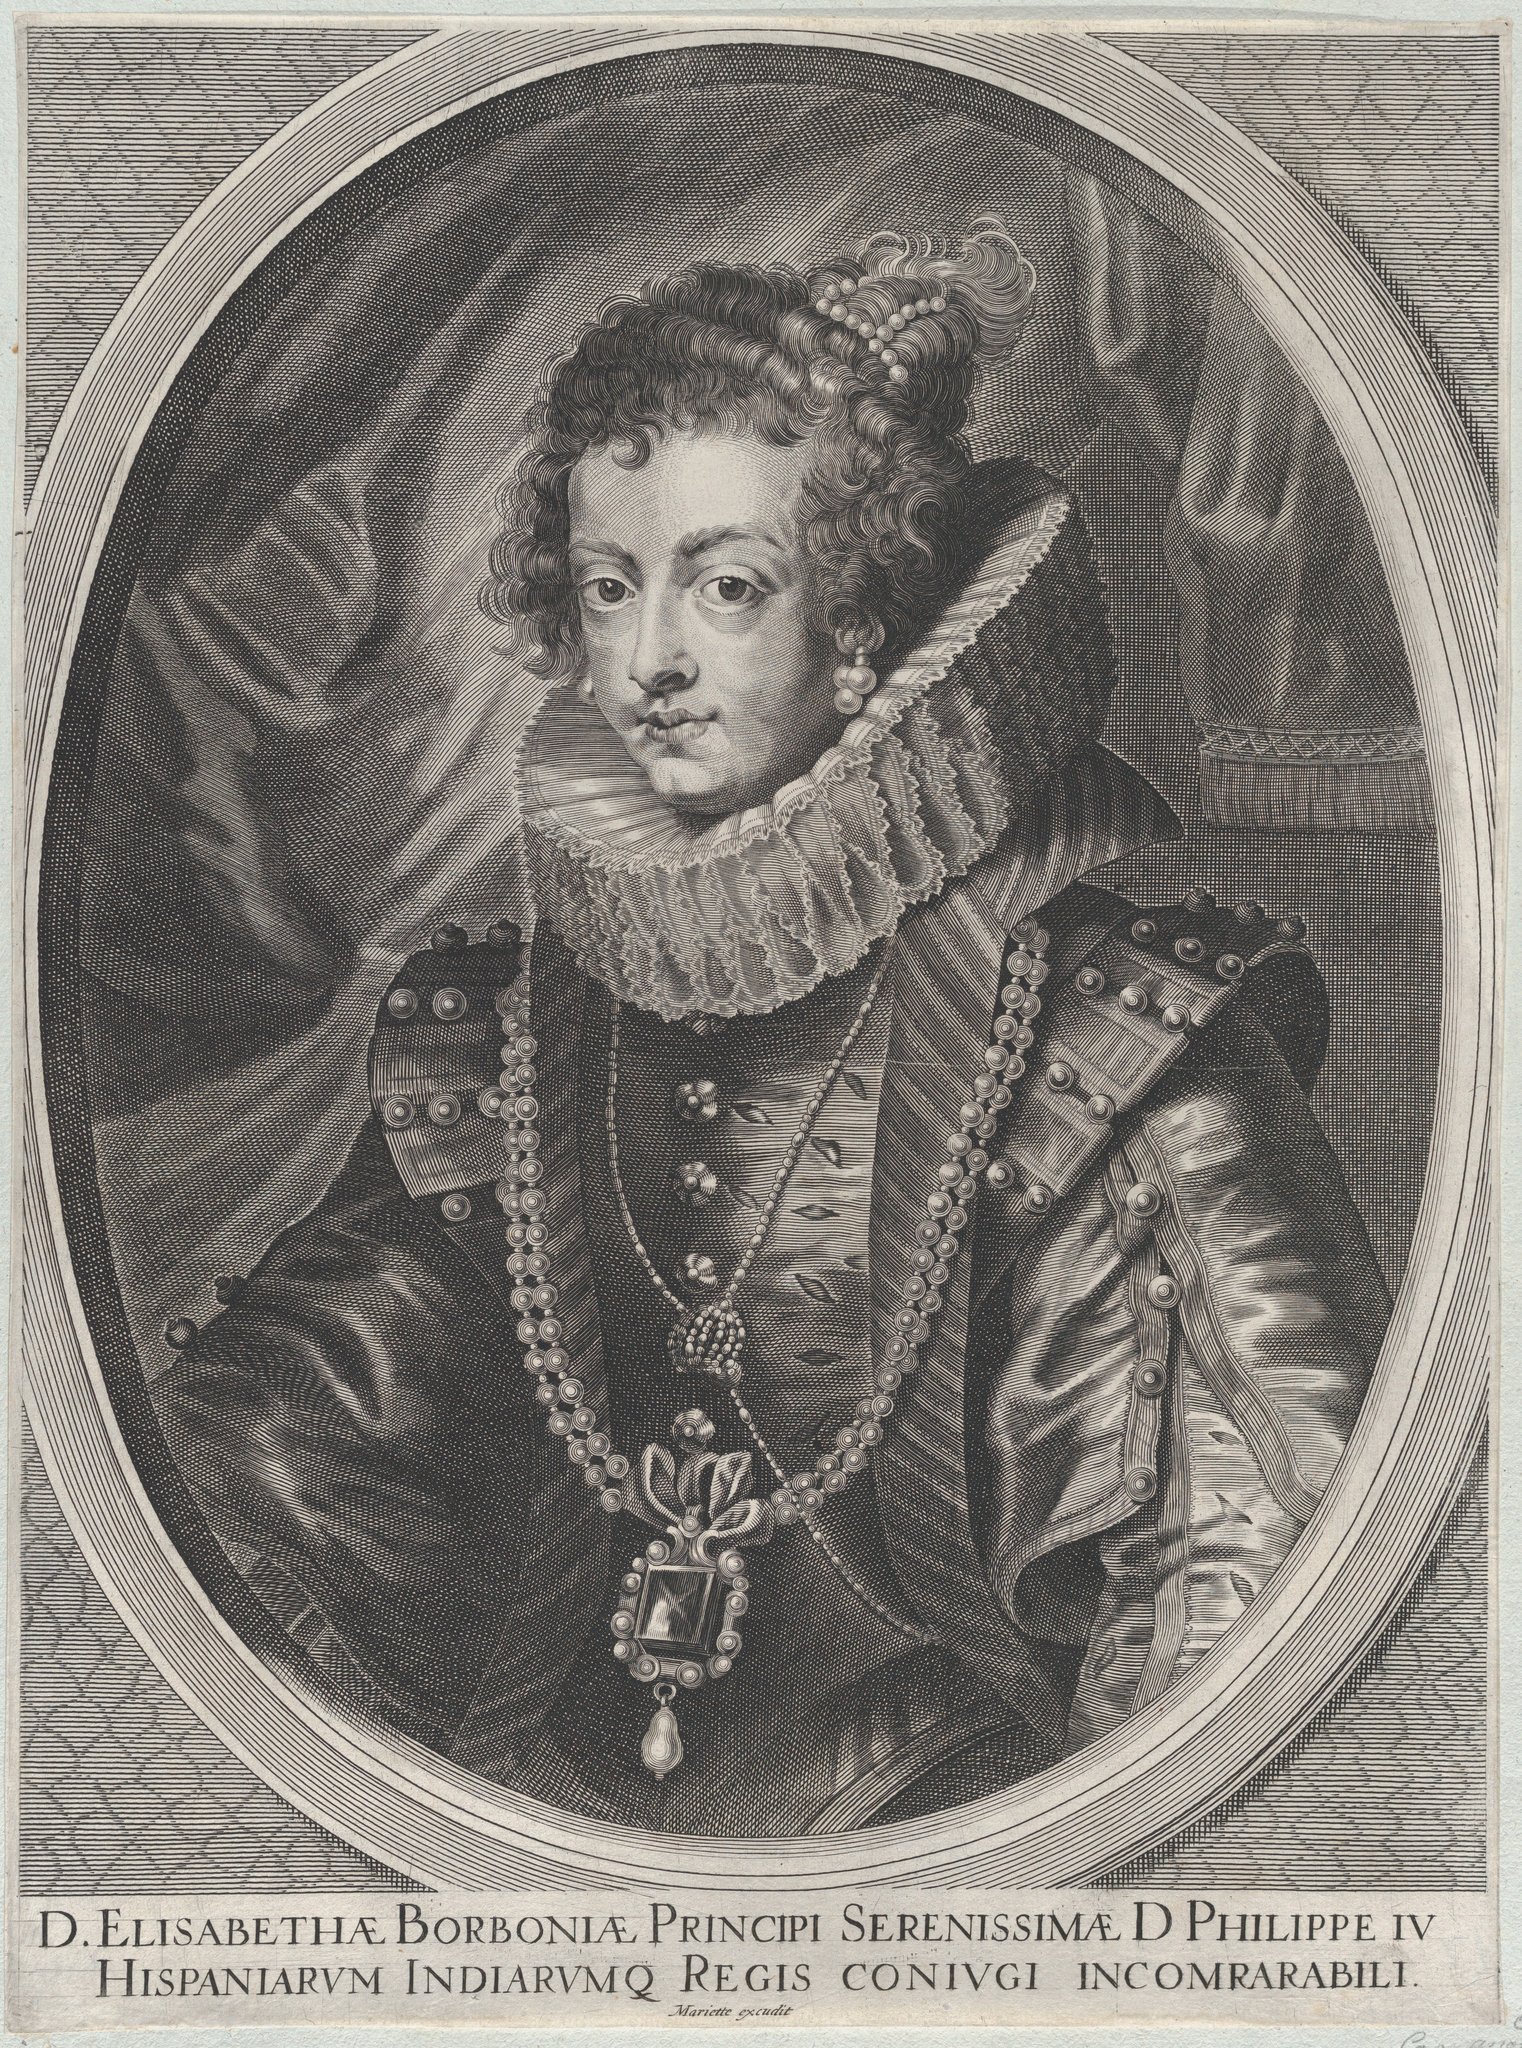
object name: print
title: Portrait of Elisabeth of Bourbon, Queen of Spain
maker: Anonymous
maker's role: artist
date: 1650-1700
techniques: engraving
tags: queens,portraits,women